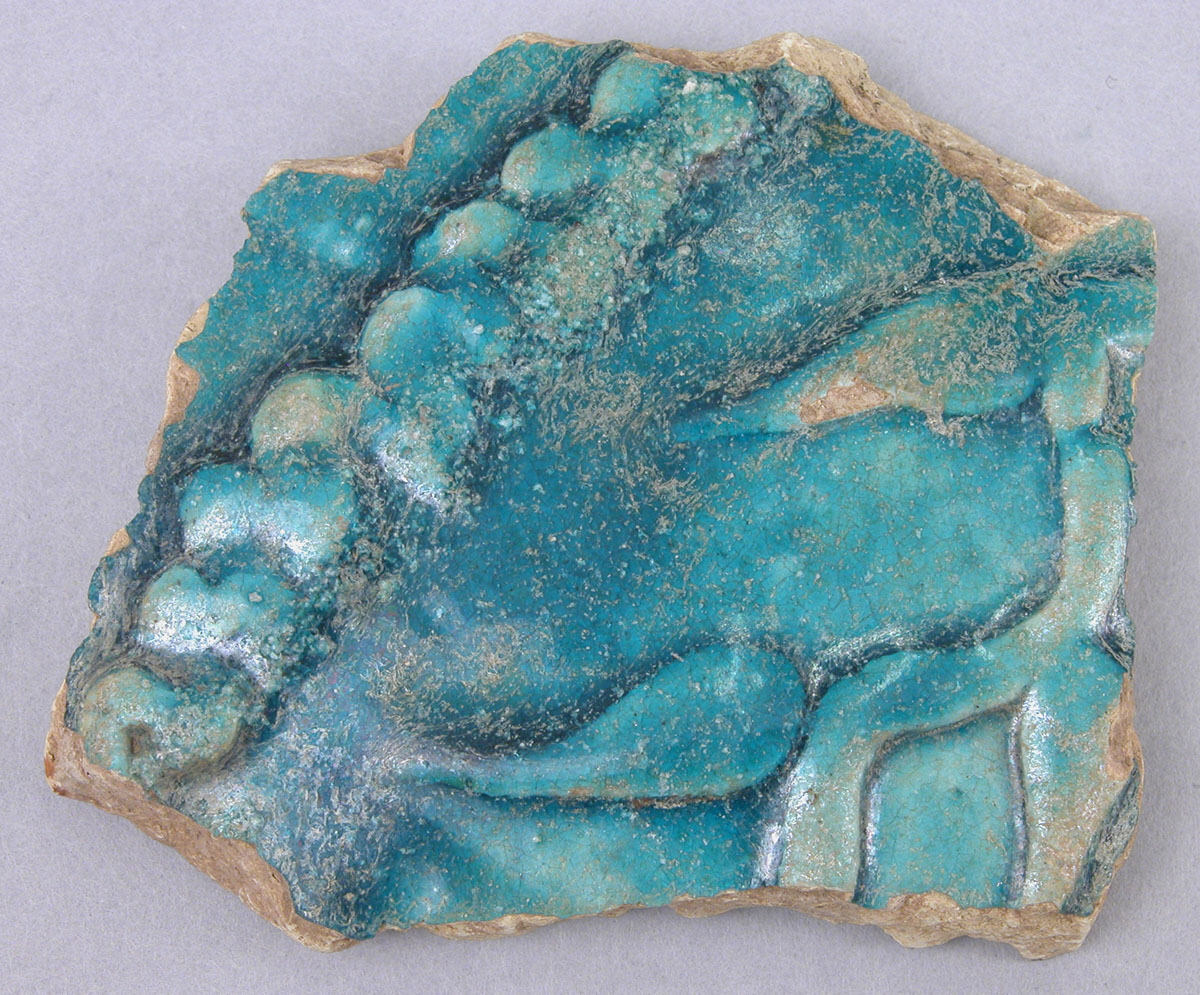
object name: fragment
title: Fragment of a Closed Vessel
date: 601-900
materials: earthenware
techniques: glazing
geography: iraq